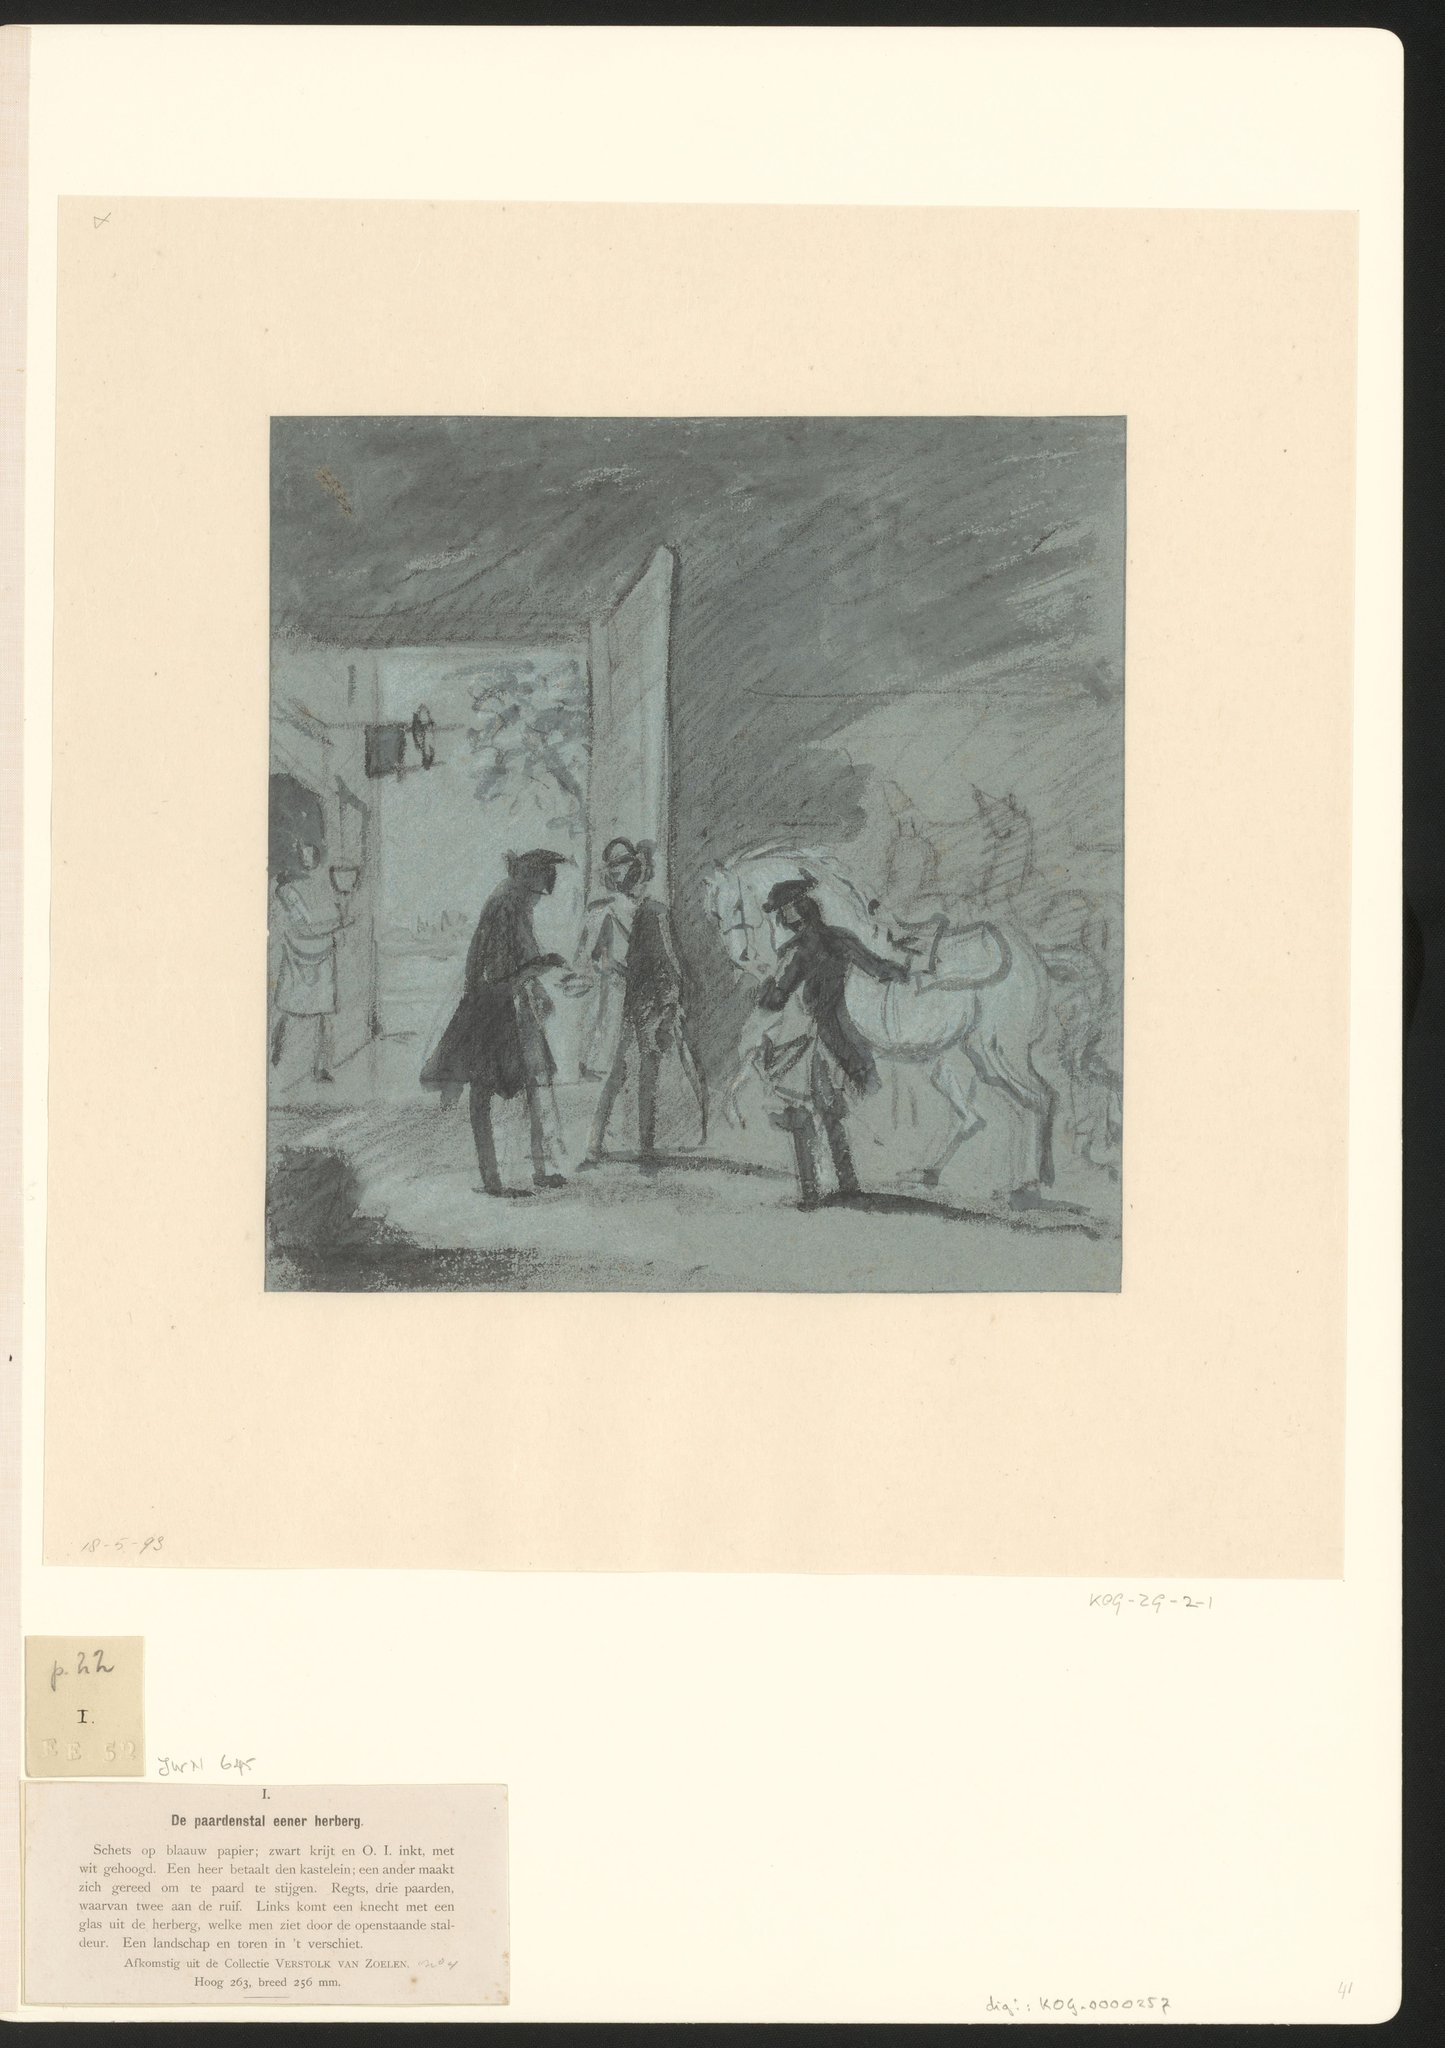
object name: drawing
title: Paardenstal in een herberg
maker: cornelis troost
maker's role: draughtsman, painter, print maker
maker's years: 1696-1750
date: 1712-1750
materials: chalk, ink, paper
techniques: brush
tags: inn, coffee-house, public house, etc., horse, stall, stable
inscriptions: collector's mark: Lugt 2488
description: Heer betaalt de herbergier in de paardenstal van een herberg.